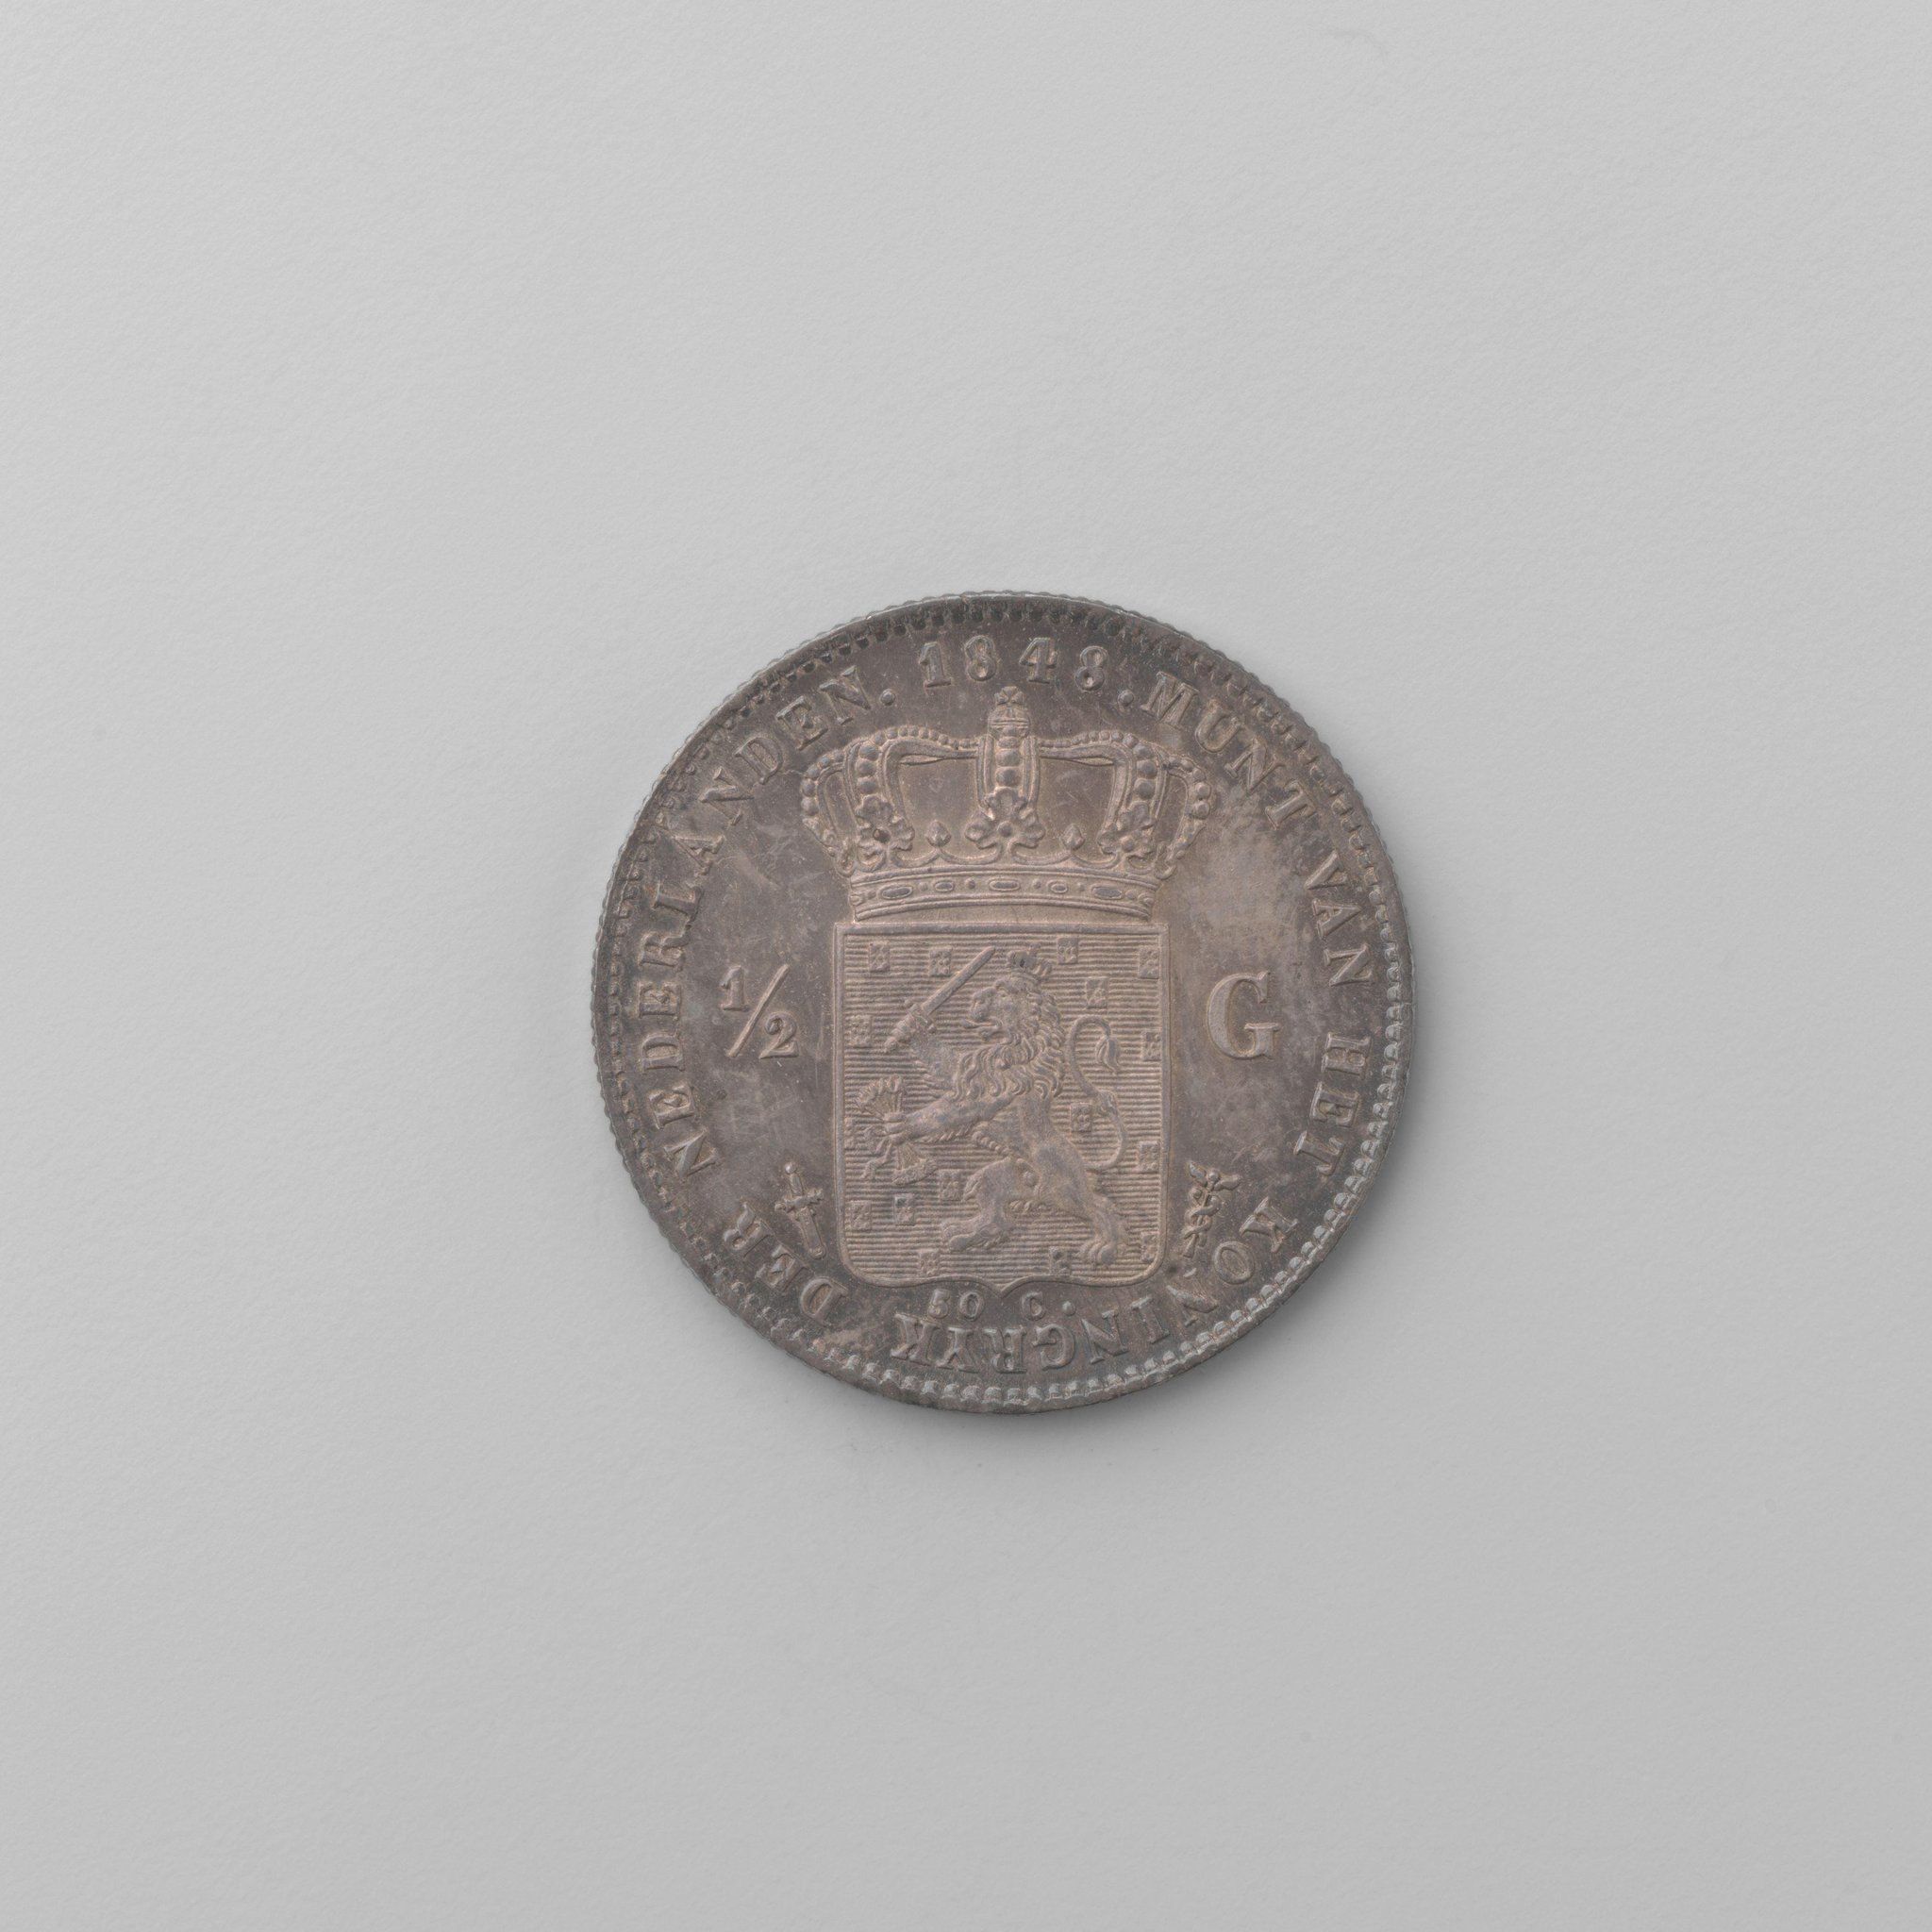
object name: coin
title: Nederland, ½ gulden, 1848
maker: william ii of the netherlands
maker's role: koning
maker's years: 1792-1849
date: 1848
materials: silver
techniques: striking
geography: utrecht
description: Zilveren munt. Voorzijde: borstbeeld naar links. Keerzijde: tussen waarde-aanduiding ½ G gekroond rijkswapenschild. Jaartal boven kroon. Kartelrand.